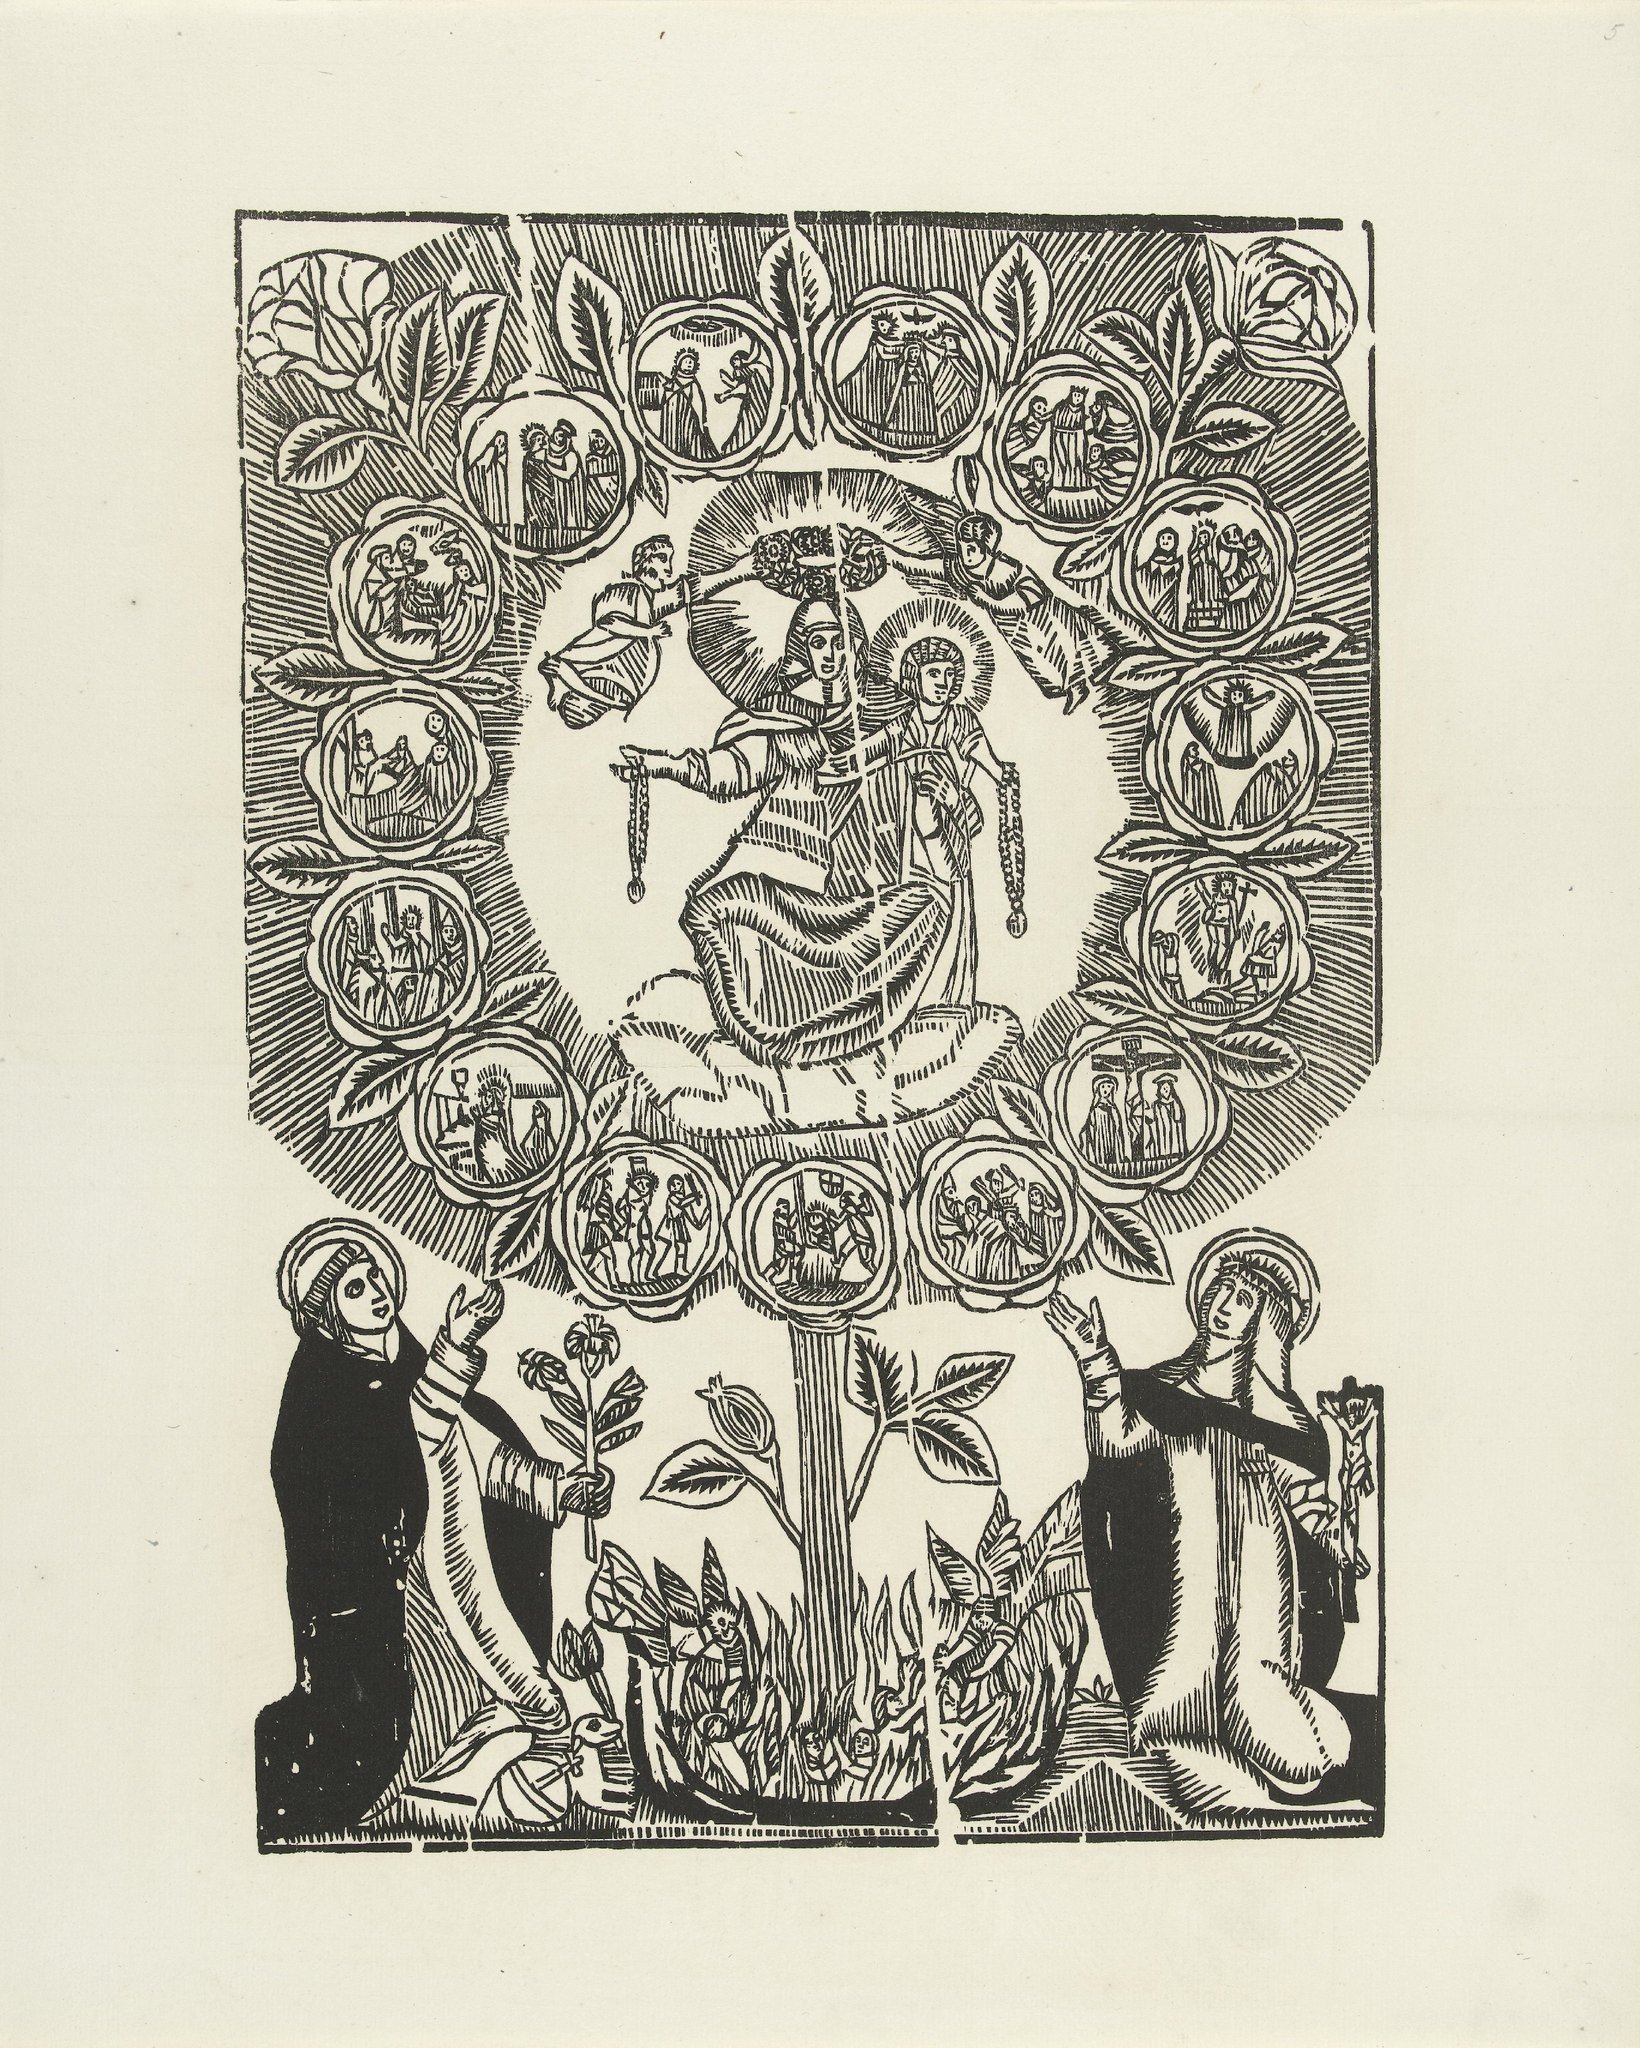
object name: popular print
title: Onze-Lieve-Vrouw van de Heilige Rozenkrans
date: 1700-1725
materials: paper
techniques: woodcut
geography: ghent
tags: madonna in a tree (+ donor(s), supplicant(s), whether or not with patron saint(s)), aids for prayer, e.g. rosary, dominic(us) guzman of calerueja, founder of the order of preachers (or dominican (black) friars; possible attributes: book, dog with flaming torch, lily, loaf of bread, rosary, star, the virgin and dominican tertiary, catherine of siena; possible attributes: book, cross, crown of thorns, crucifix, demon under foot, heart (with cross), lily, plague-stricken, ring, rosary, stigmata, madonna of the rosary, the (fifteen) secrets of the rosary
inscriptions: collector's mark: Lugt 2760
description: Onze-Lieve-Vrouw van de Heilige Rozenkrans. Maria met kind op schoot, rozenkransen in de hand, zittend in de kruin van een boom. Omringd door 15 medaillons voorstellende de mysteriën van de Rozenkrans. Knielend onder de boom de heilige Dominicus en de heilige Catharina van Siena.